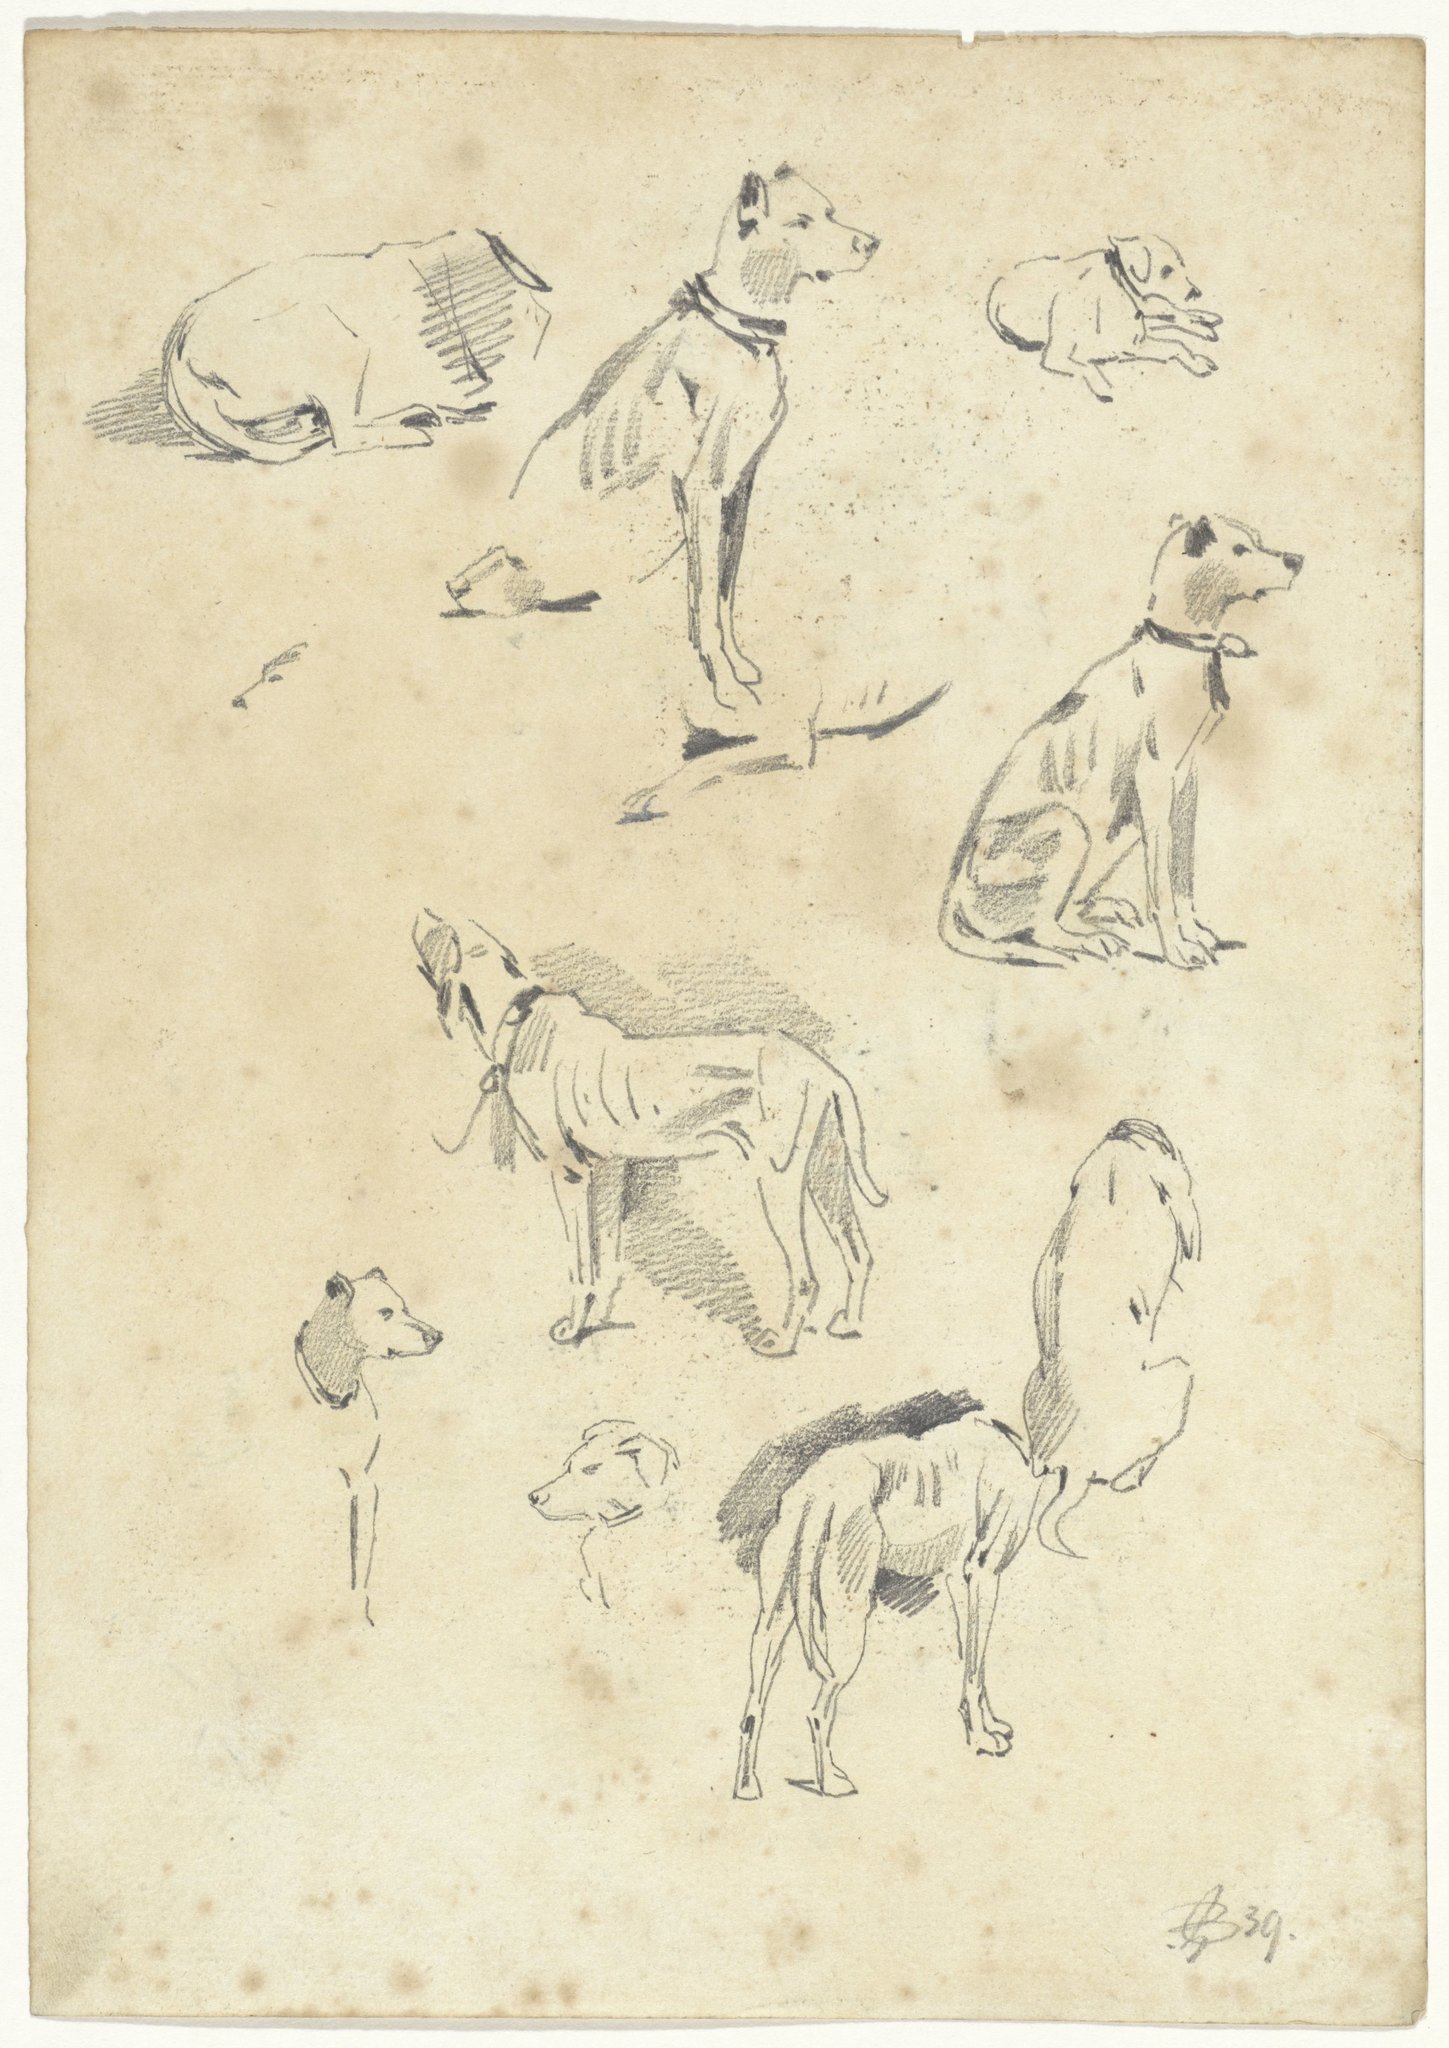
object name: drawing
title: Studies van honden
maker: pieter van loon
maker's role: draughtsman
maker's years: 1801-1873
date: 1839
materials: paper, pencil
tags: dog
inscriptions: date: ‘39’